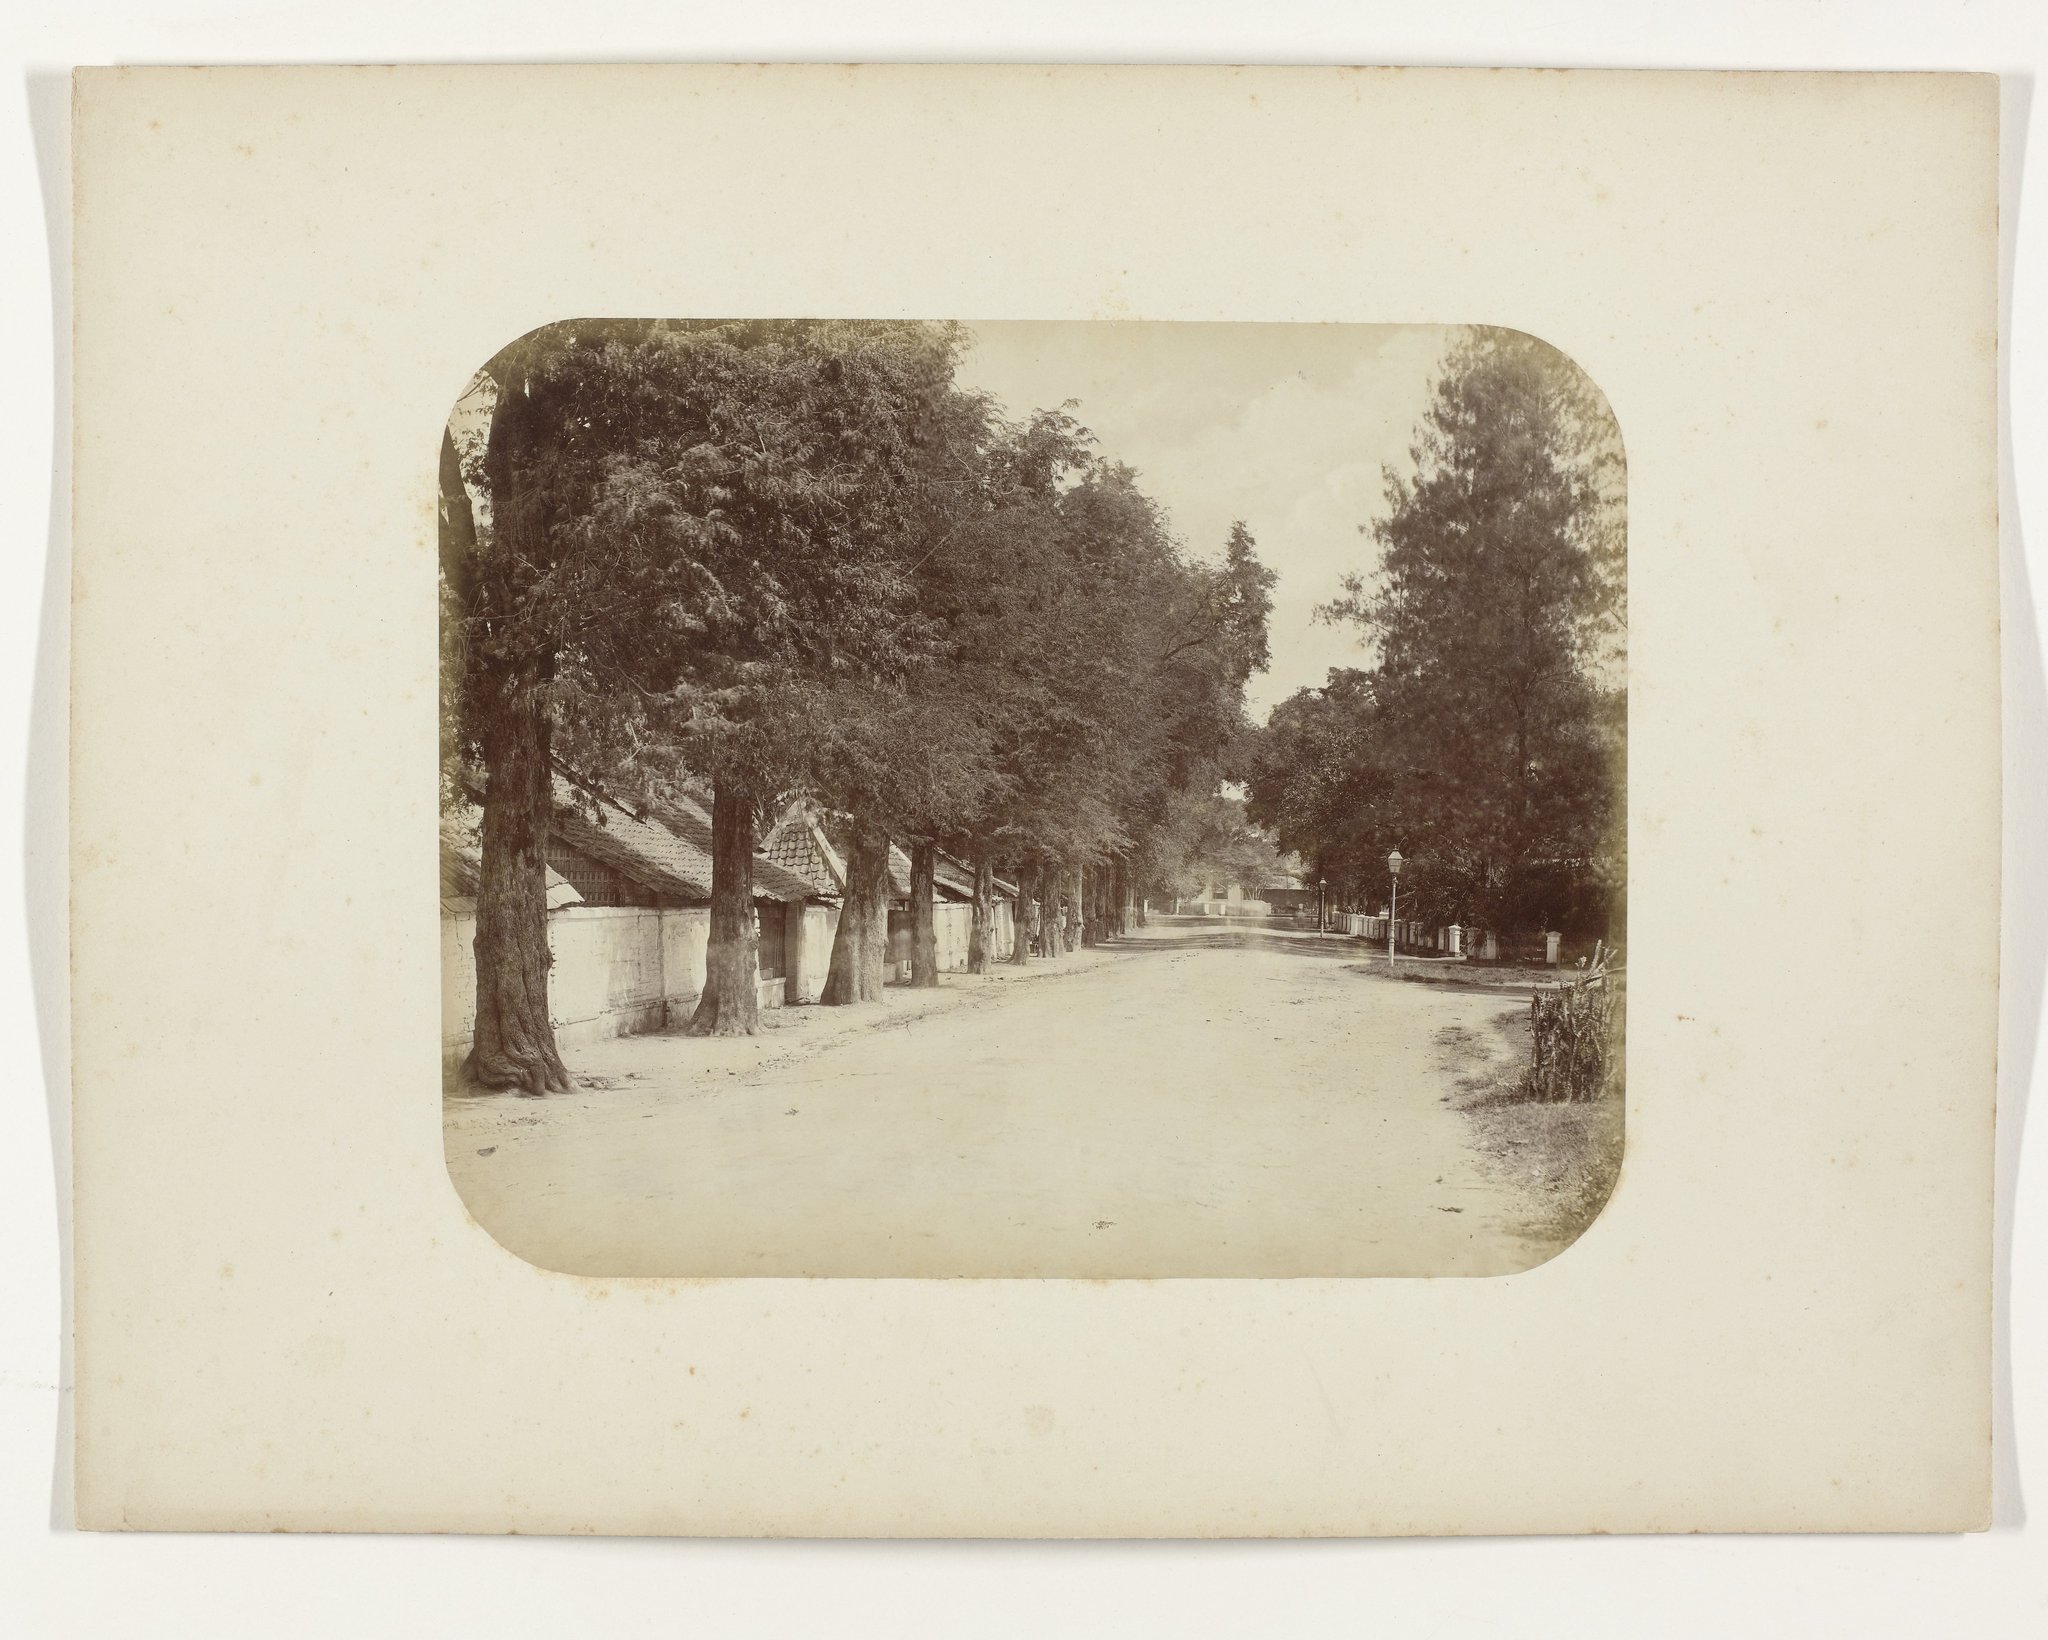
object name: photograph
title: Een straat in Surabaya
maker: herman salzwedel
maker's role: fotograaf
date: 1876-1884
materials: photographic support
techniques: albumen print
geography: surabaya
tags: utrecht, the hague, colonial system, public road, surabaya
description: Een straat in Surabaya met links een rij bomen met achter de muurtjes huizen. Rechts van de weg twee lantaarnpalen. Onderdeel van het fotoalbum door de Soerabayasche Vereeniging van Suikerfabrikanten aangeboden aan Frederik Beyerinck, resident van Soerabaja.